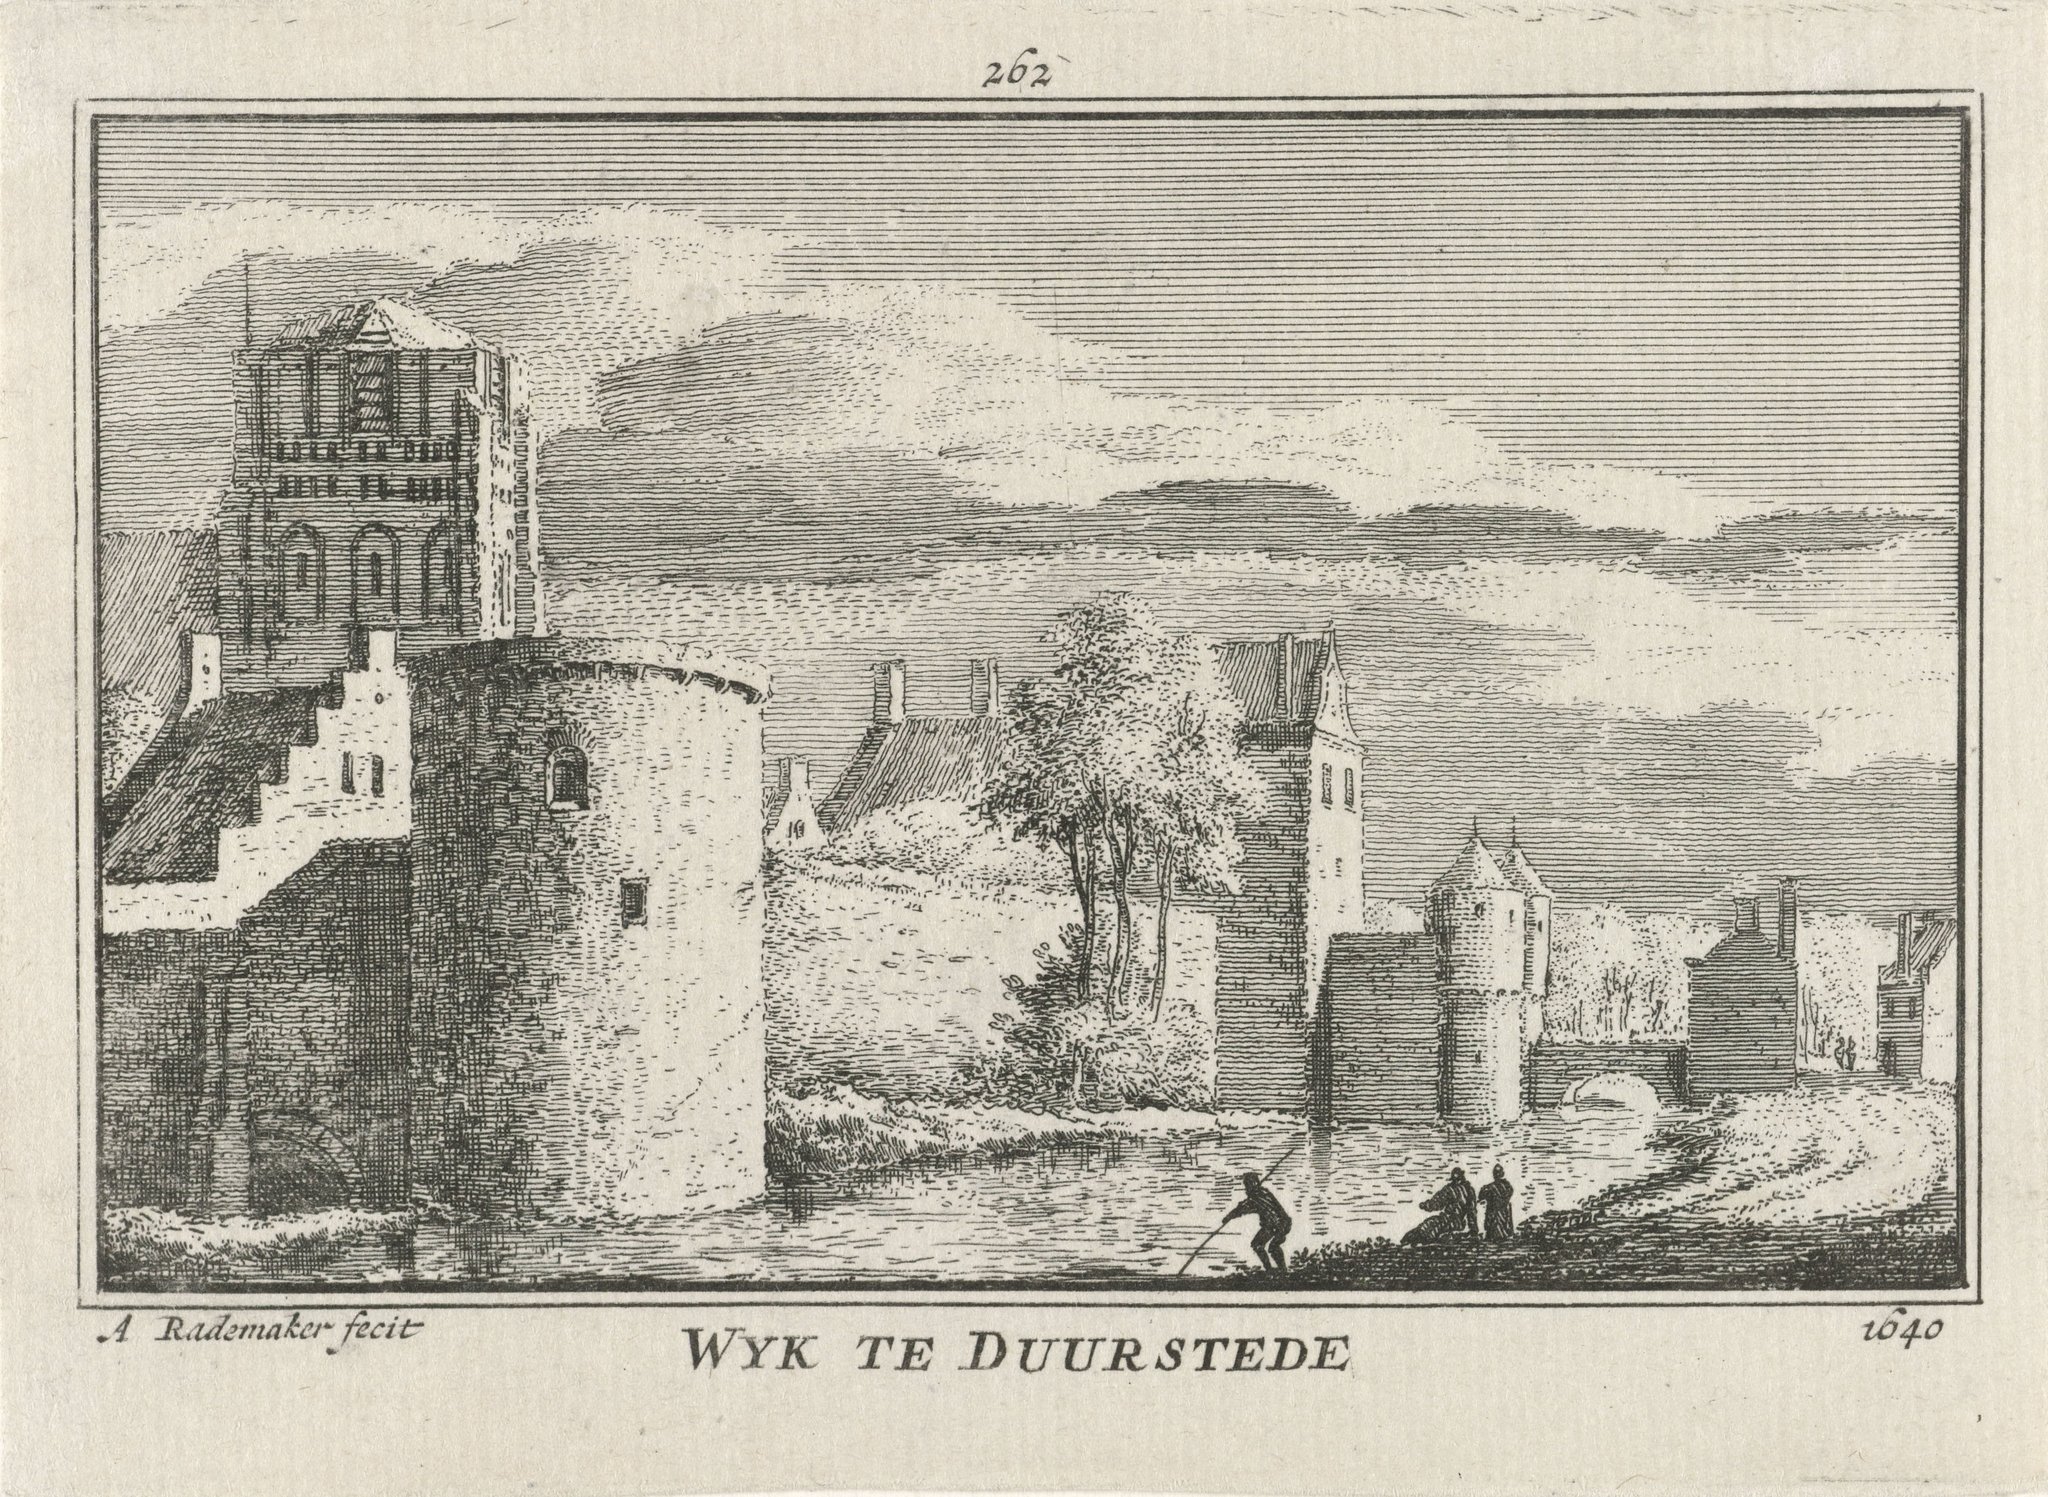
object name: print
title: Gezicht op Wijk bij Duurstede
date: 1727-1733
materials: paper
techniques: etching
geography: amsterdam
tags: city-walls, wijk bij duurstede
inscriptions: collector's mark: Lugt 2228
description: Illustratie uit: Abraham Rademaker, Matthaeus Brouërius van Niedek, Isaac Le Long, Kabinet van Nederlandsche en Kleefsche outheden en (...) voorname stads- en landgebouwen, Willem Barents en Antoni Schoonenburg: Amsterdam, 1727-1733, ill. nr. 262.